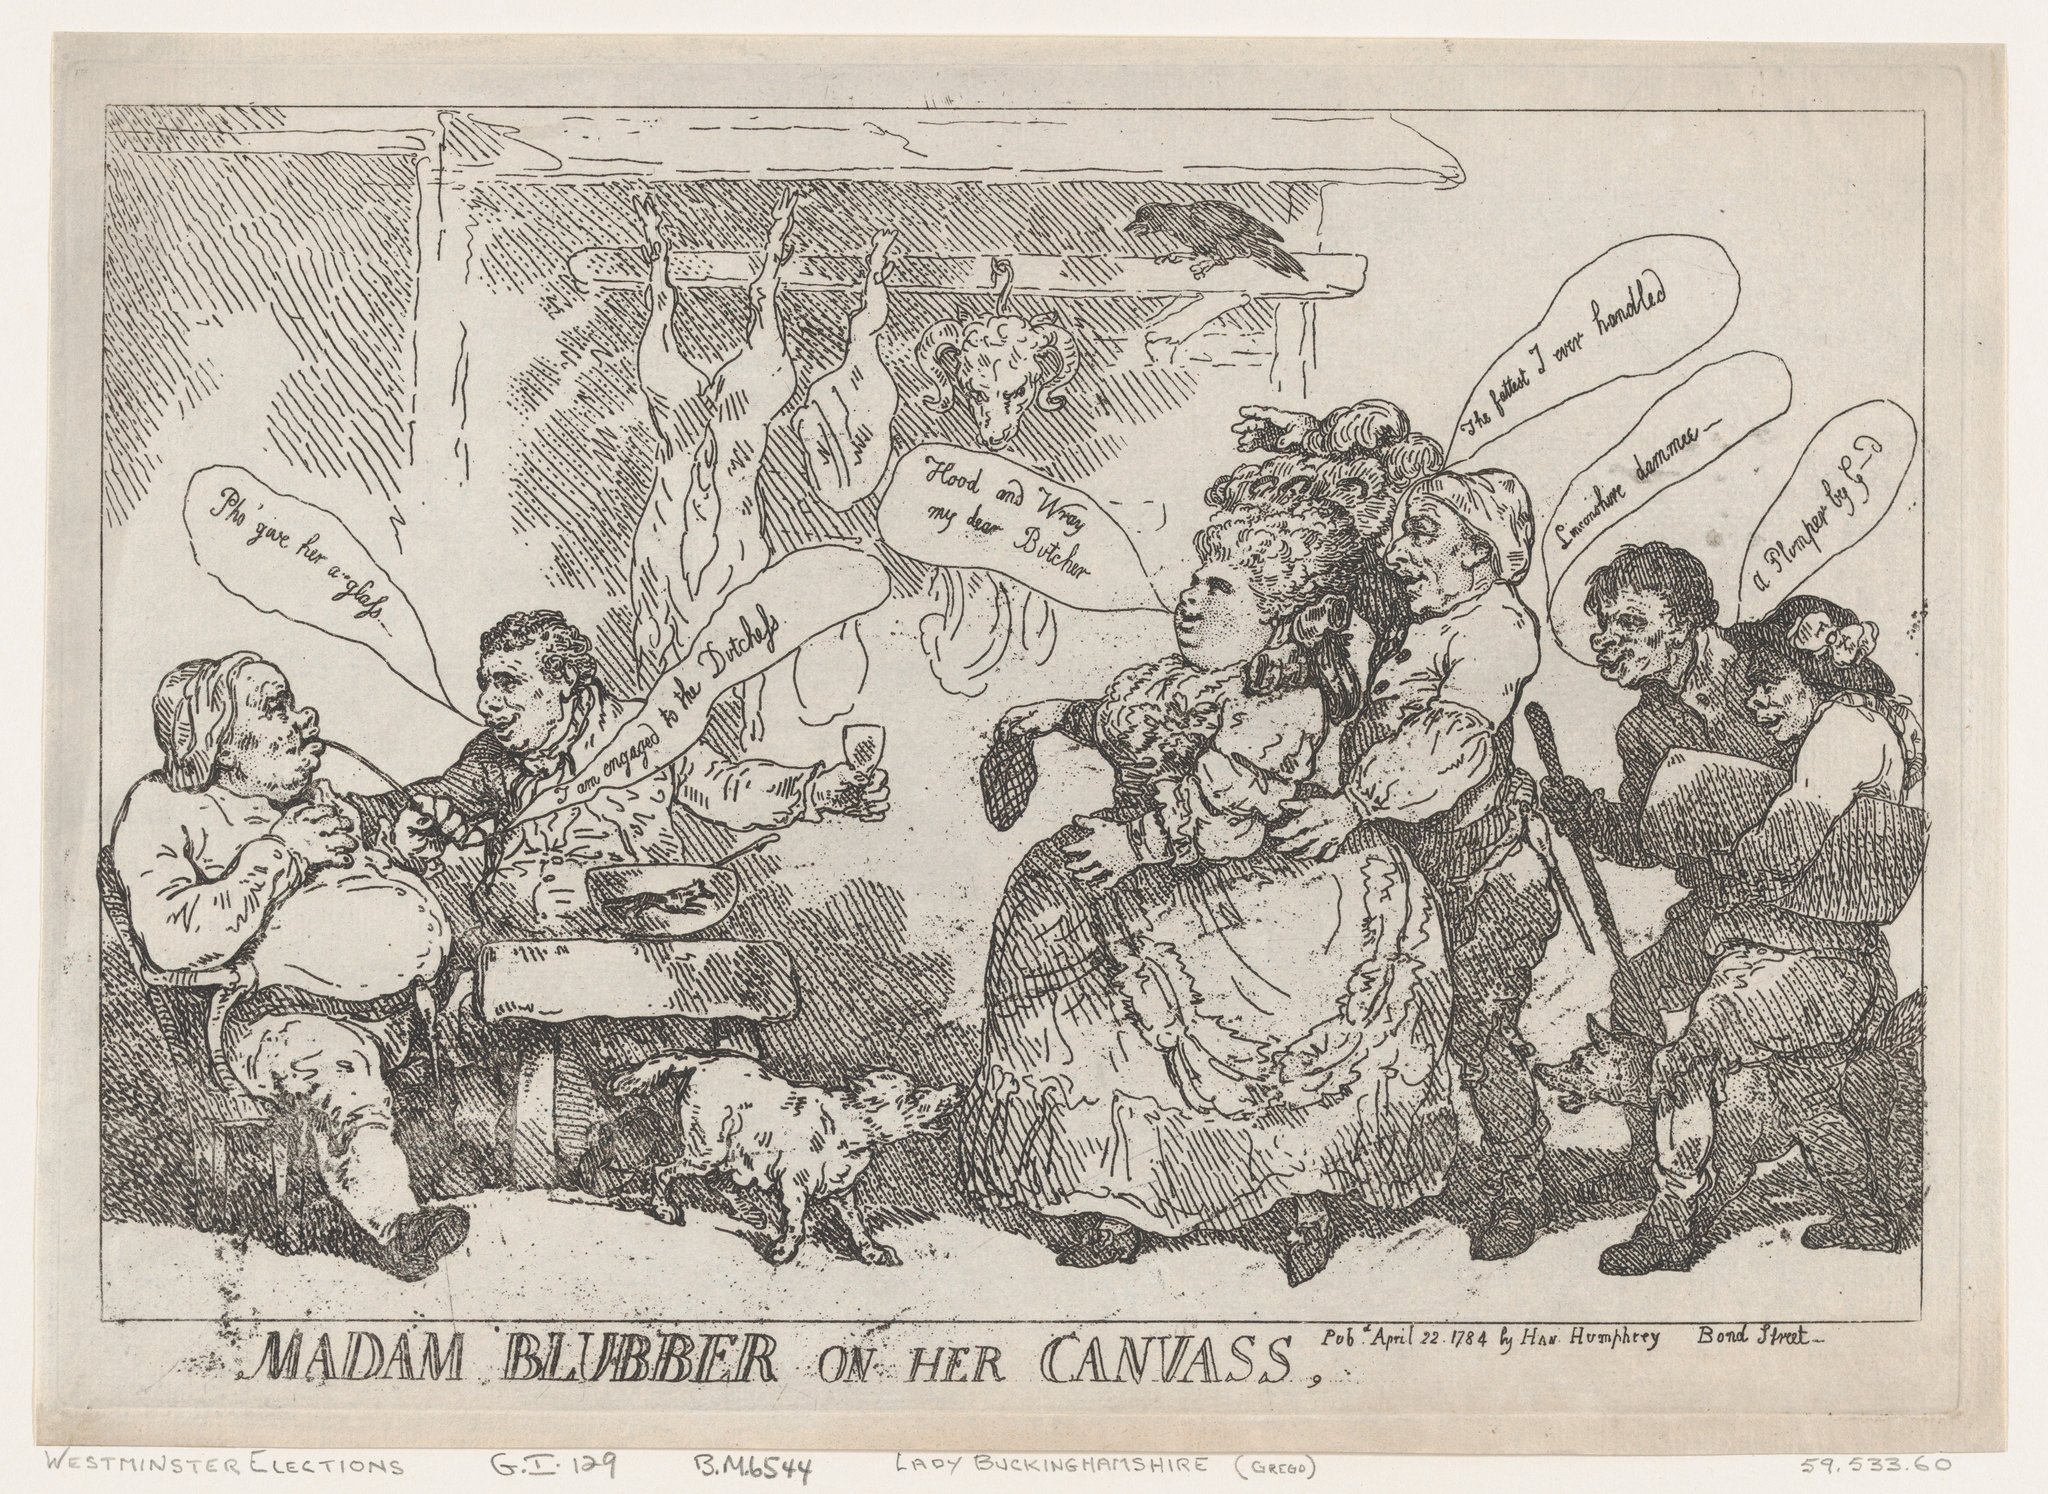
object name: print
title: Madam Blubber On Her Canvass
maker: thomas rowlandson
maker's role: artist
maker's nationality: british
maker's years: 1757-1827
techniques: etching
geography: london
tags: satire,men,women